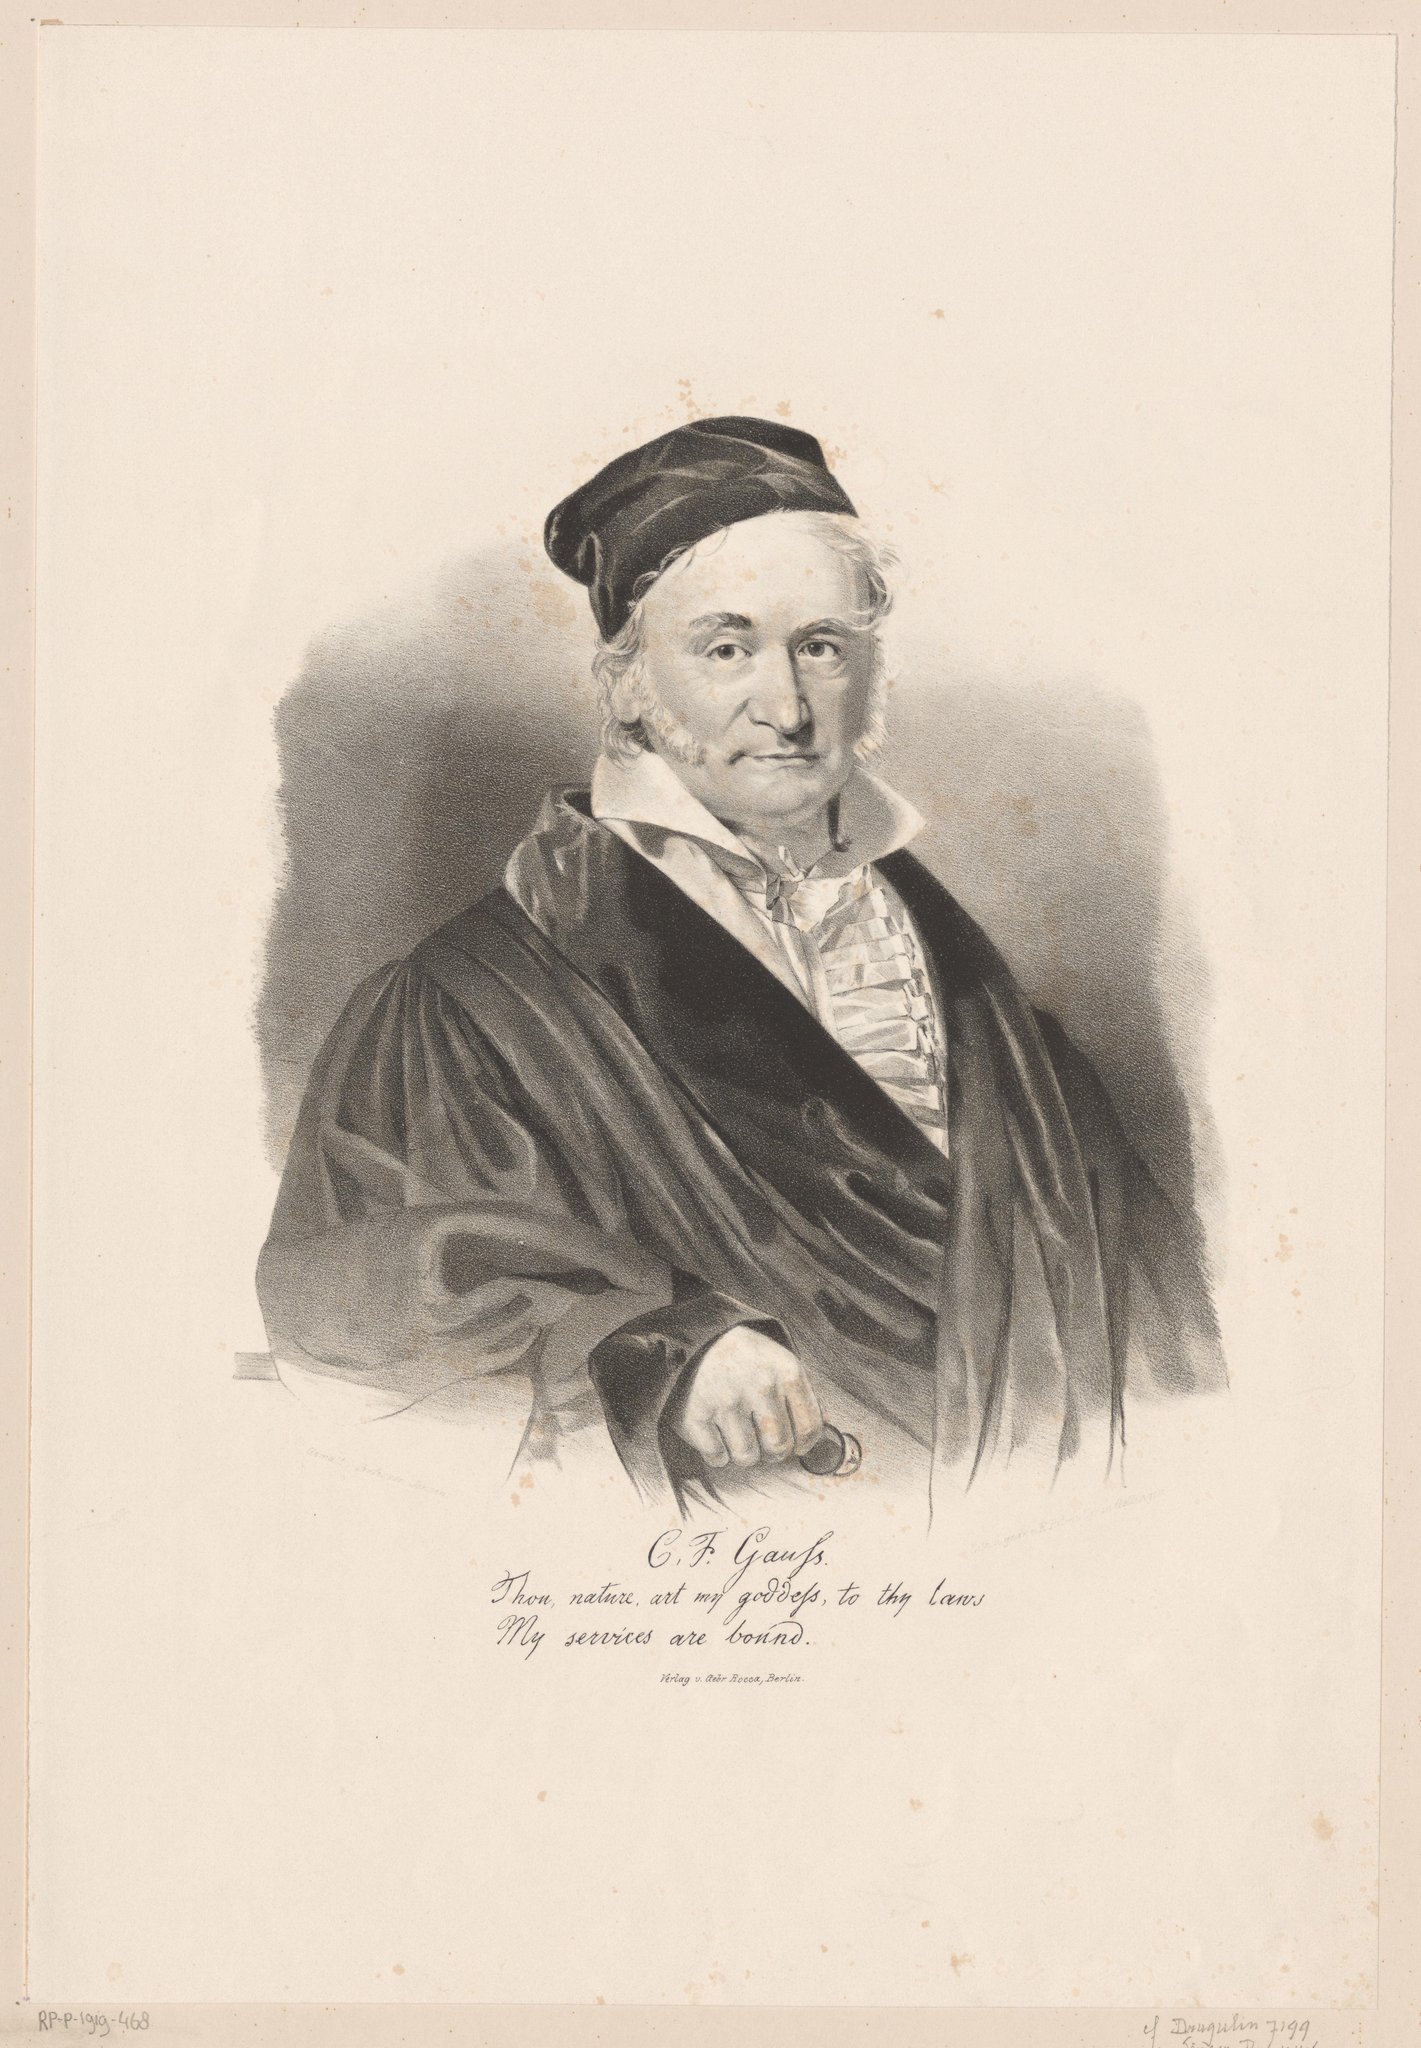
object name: print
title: Portret van Carl Friedrich Gauss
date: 1830-1863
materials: paper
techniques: lithograph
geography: berlin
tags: physicist, historical persons, mathematics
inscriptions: collector's mark: Lugt 2228